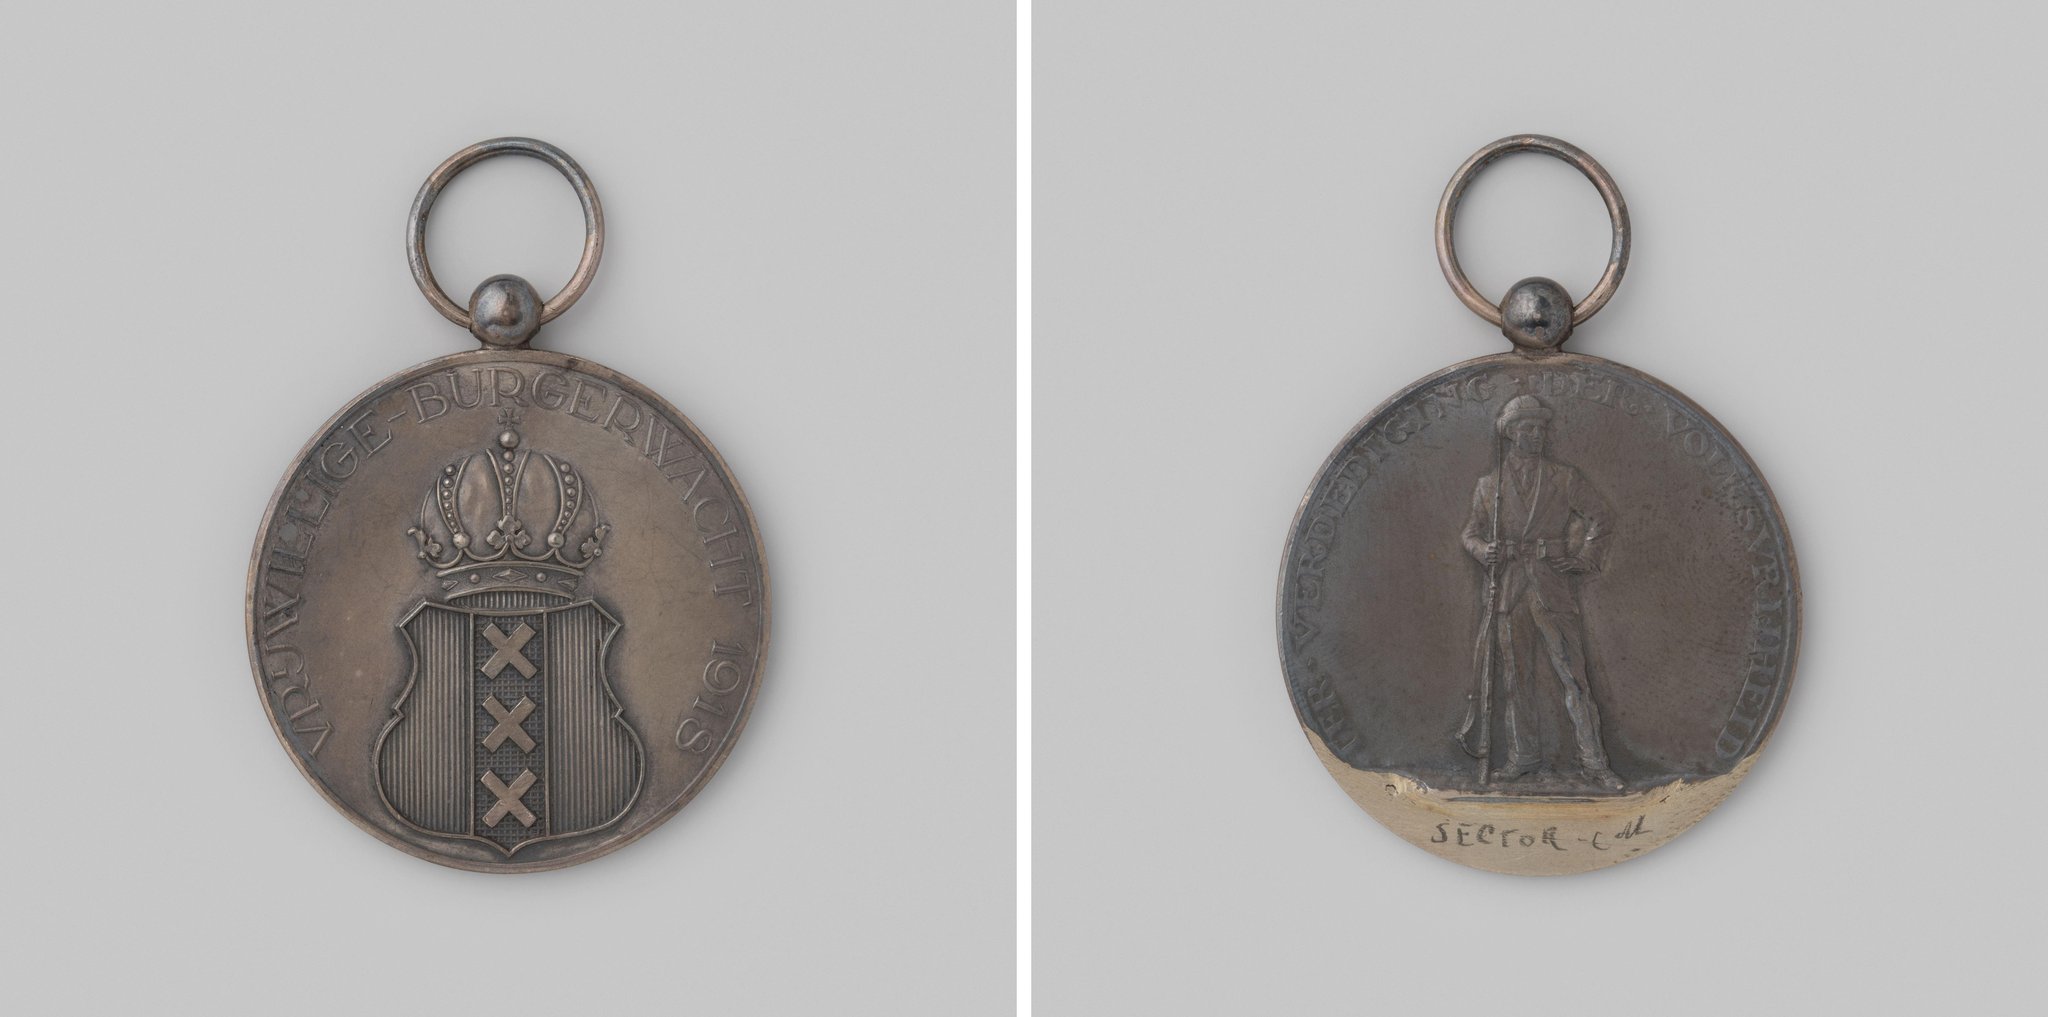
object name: draagpenning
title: Draagpenning van de Vrijwillige Burgerwacht Amsterdam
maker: Anonymous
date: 1918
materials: metal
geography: amsterdam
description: Metalen draagpenning met knop en ring. Voorzijde: gekroond wapen van Amsterdam met omschrift: VRIJWILLIGE BURGERWACHT 1918. Keerzijde: staande burger, iets naar rechts gewend, met geweer aan de voet en patroonkoppel om het middel. Omschrift: TER VERDEDIGING DER VOLKSVRIJHEID. Afsnede: onbekend.